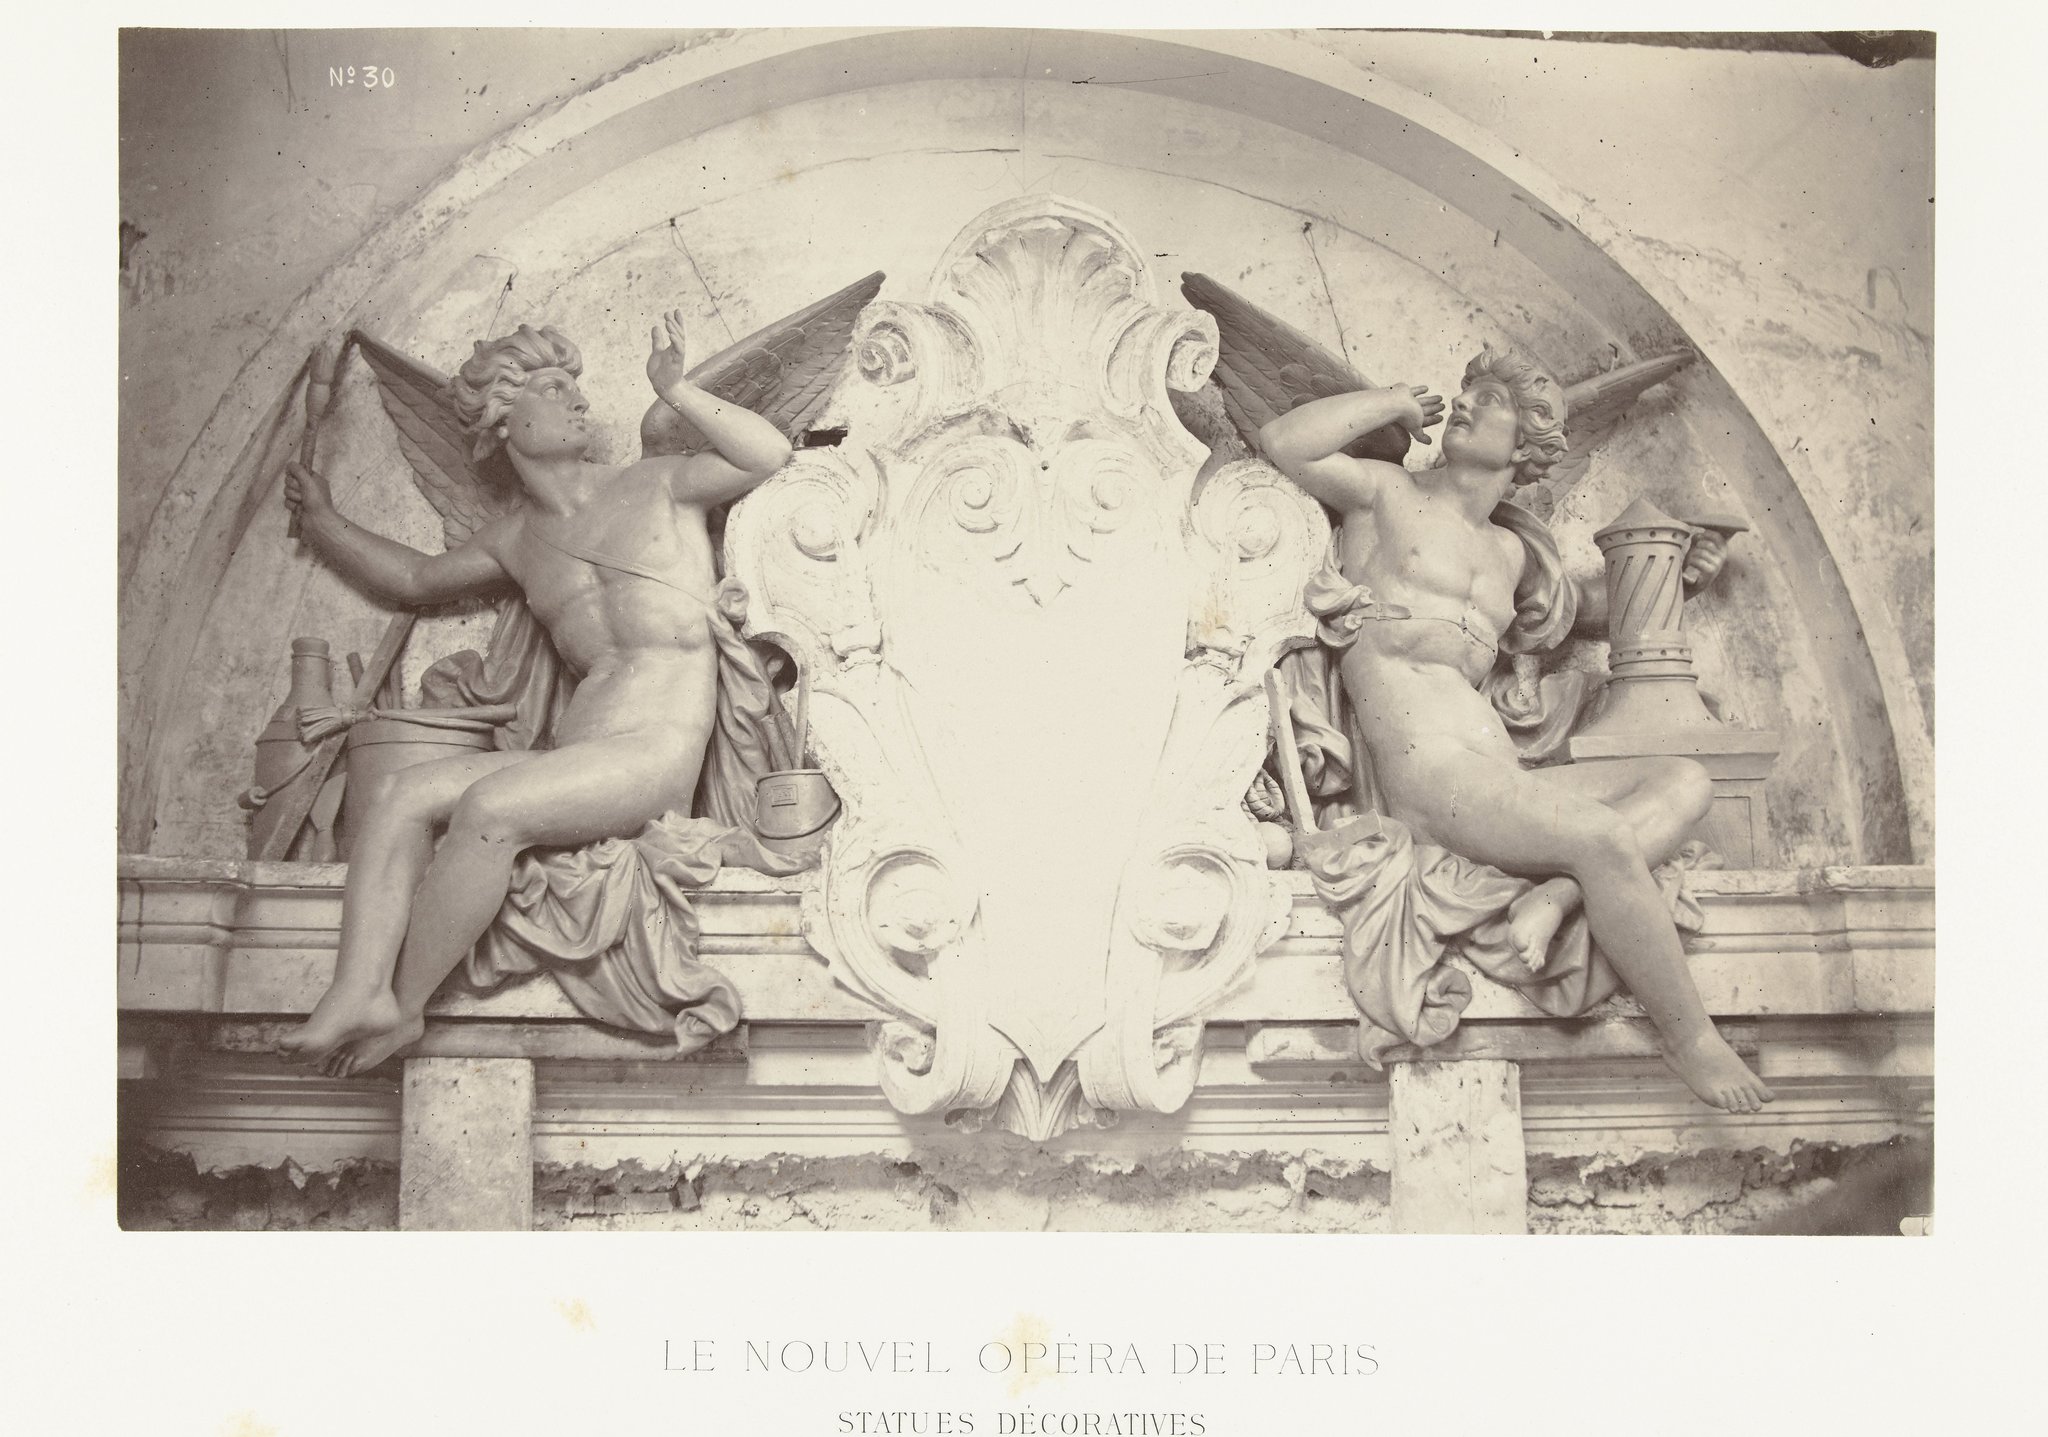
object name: photograph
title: 30. Le nouvel Opéra de Paris. Statues decoratives.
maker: louis-emile durandelle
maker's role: fotograaf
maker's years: 1839-1917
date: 1878-1881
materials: photographic support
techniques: albumen print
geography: paris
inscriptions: number: ‘30’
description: bij boek in Bibliotheek RMA, Zie Frizot, pp. 217-223, vgl G. Vicaire, Manuel de l'amateur de livres du XIXe siècle, vol. 3, column 870.